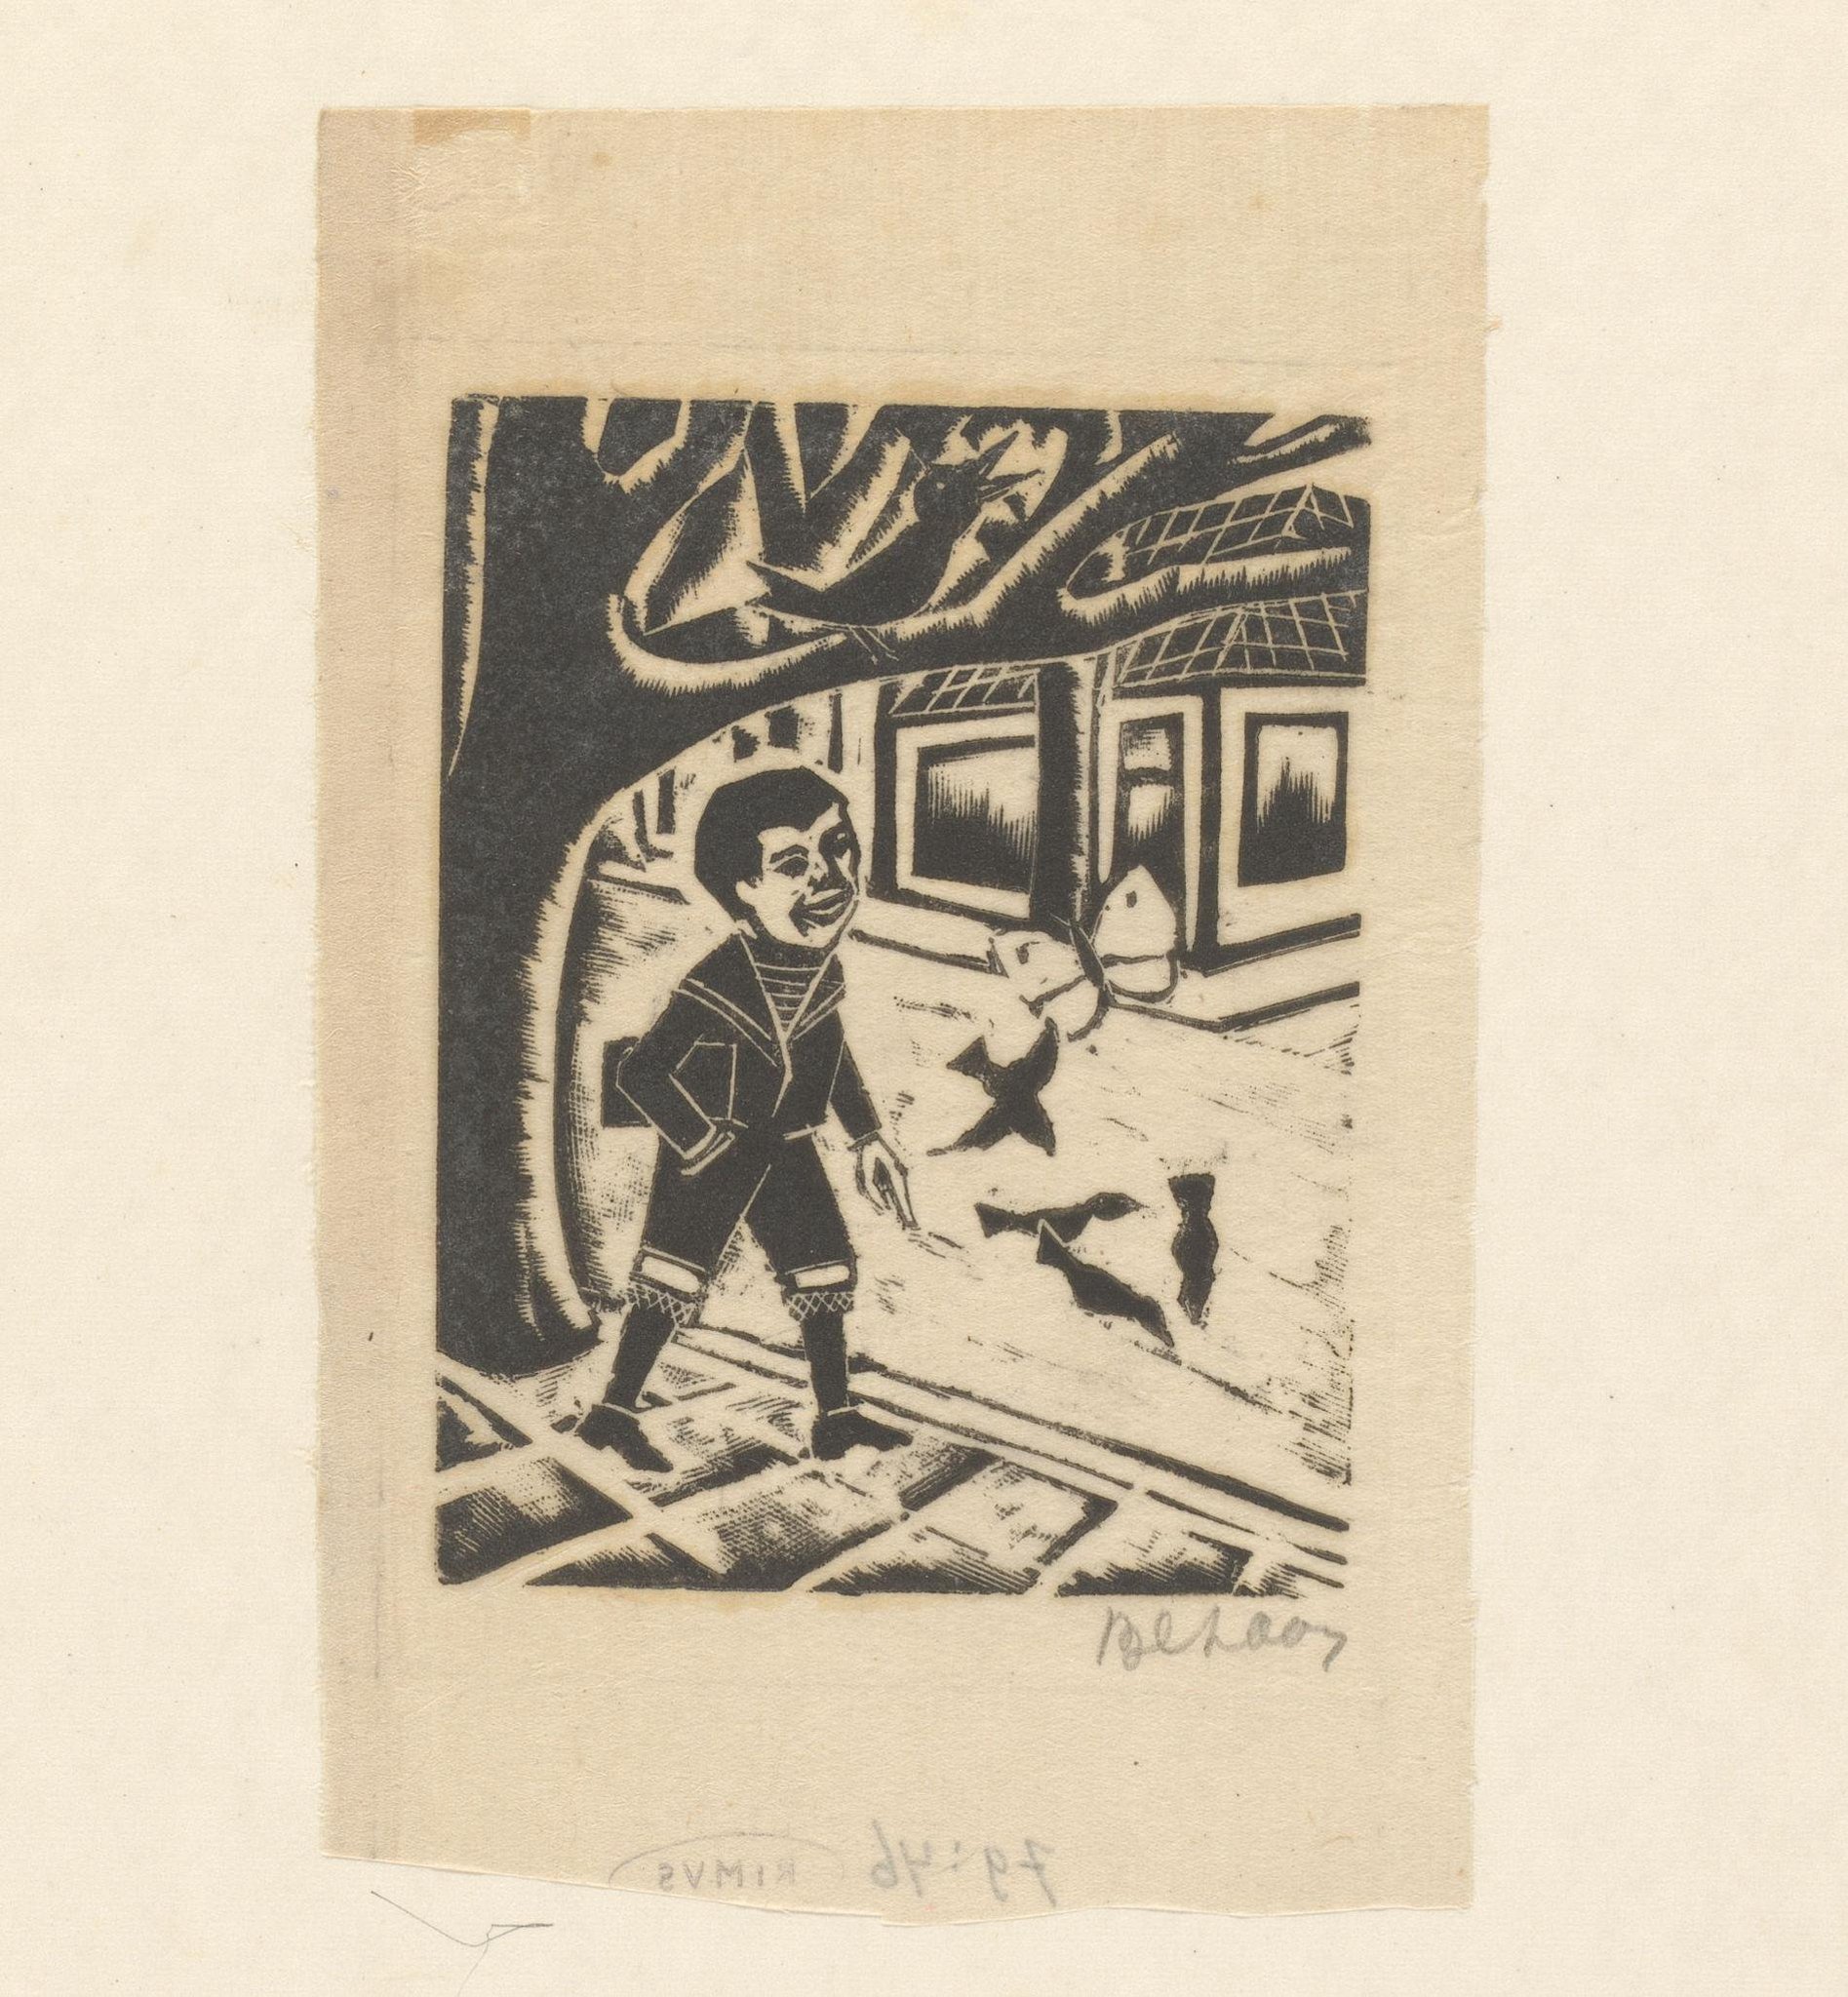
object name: print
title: Lente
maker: jo bezaan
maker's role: draughtsman, print maker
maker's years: 1894-1952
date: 1941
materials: paper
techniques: engraving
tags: spring, 'ver'; 'primavera' (ripa), birds, boy (child between toddler and youth), insects: butterfly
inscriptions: collector's mark: Lugt 2228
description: Deze prent was bestemd voor: Hattum, Jac. van. Van Odrimond, Millimas en anderen. Putten: D.J. Terwee, [1941]. De prent is echter nooit in de publicatie opgenomen.